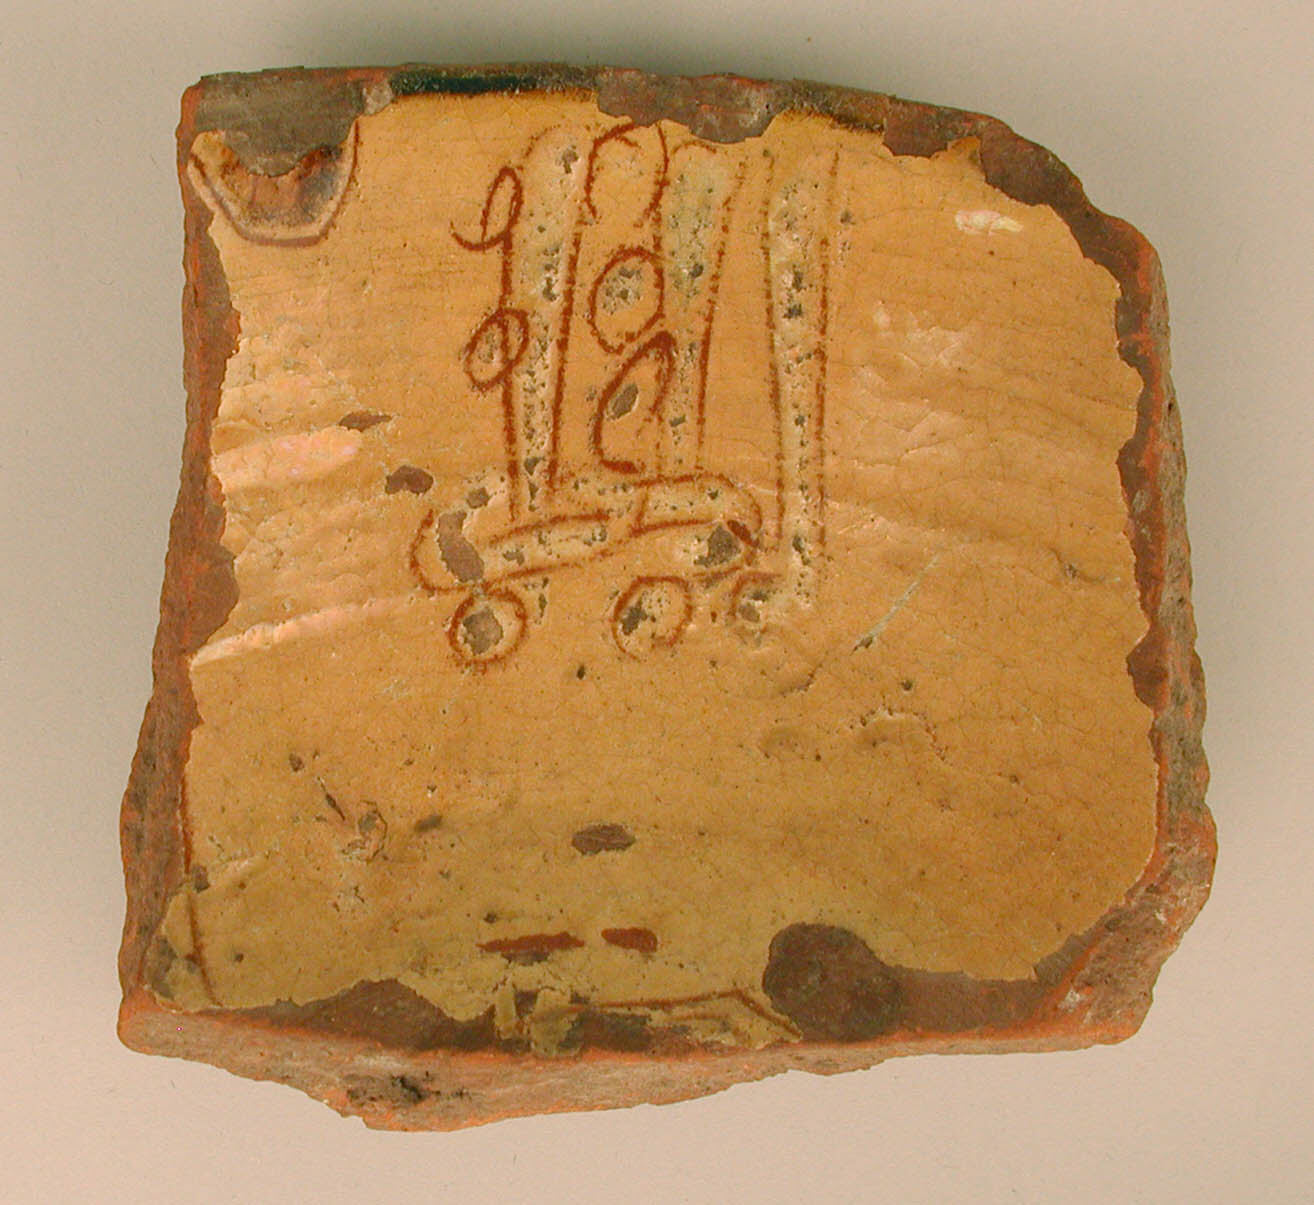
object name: ceramic fragment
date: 1301-1500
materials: earthenware, glaze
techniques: coloring, incising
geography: egypt